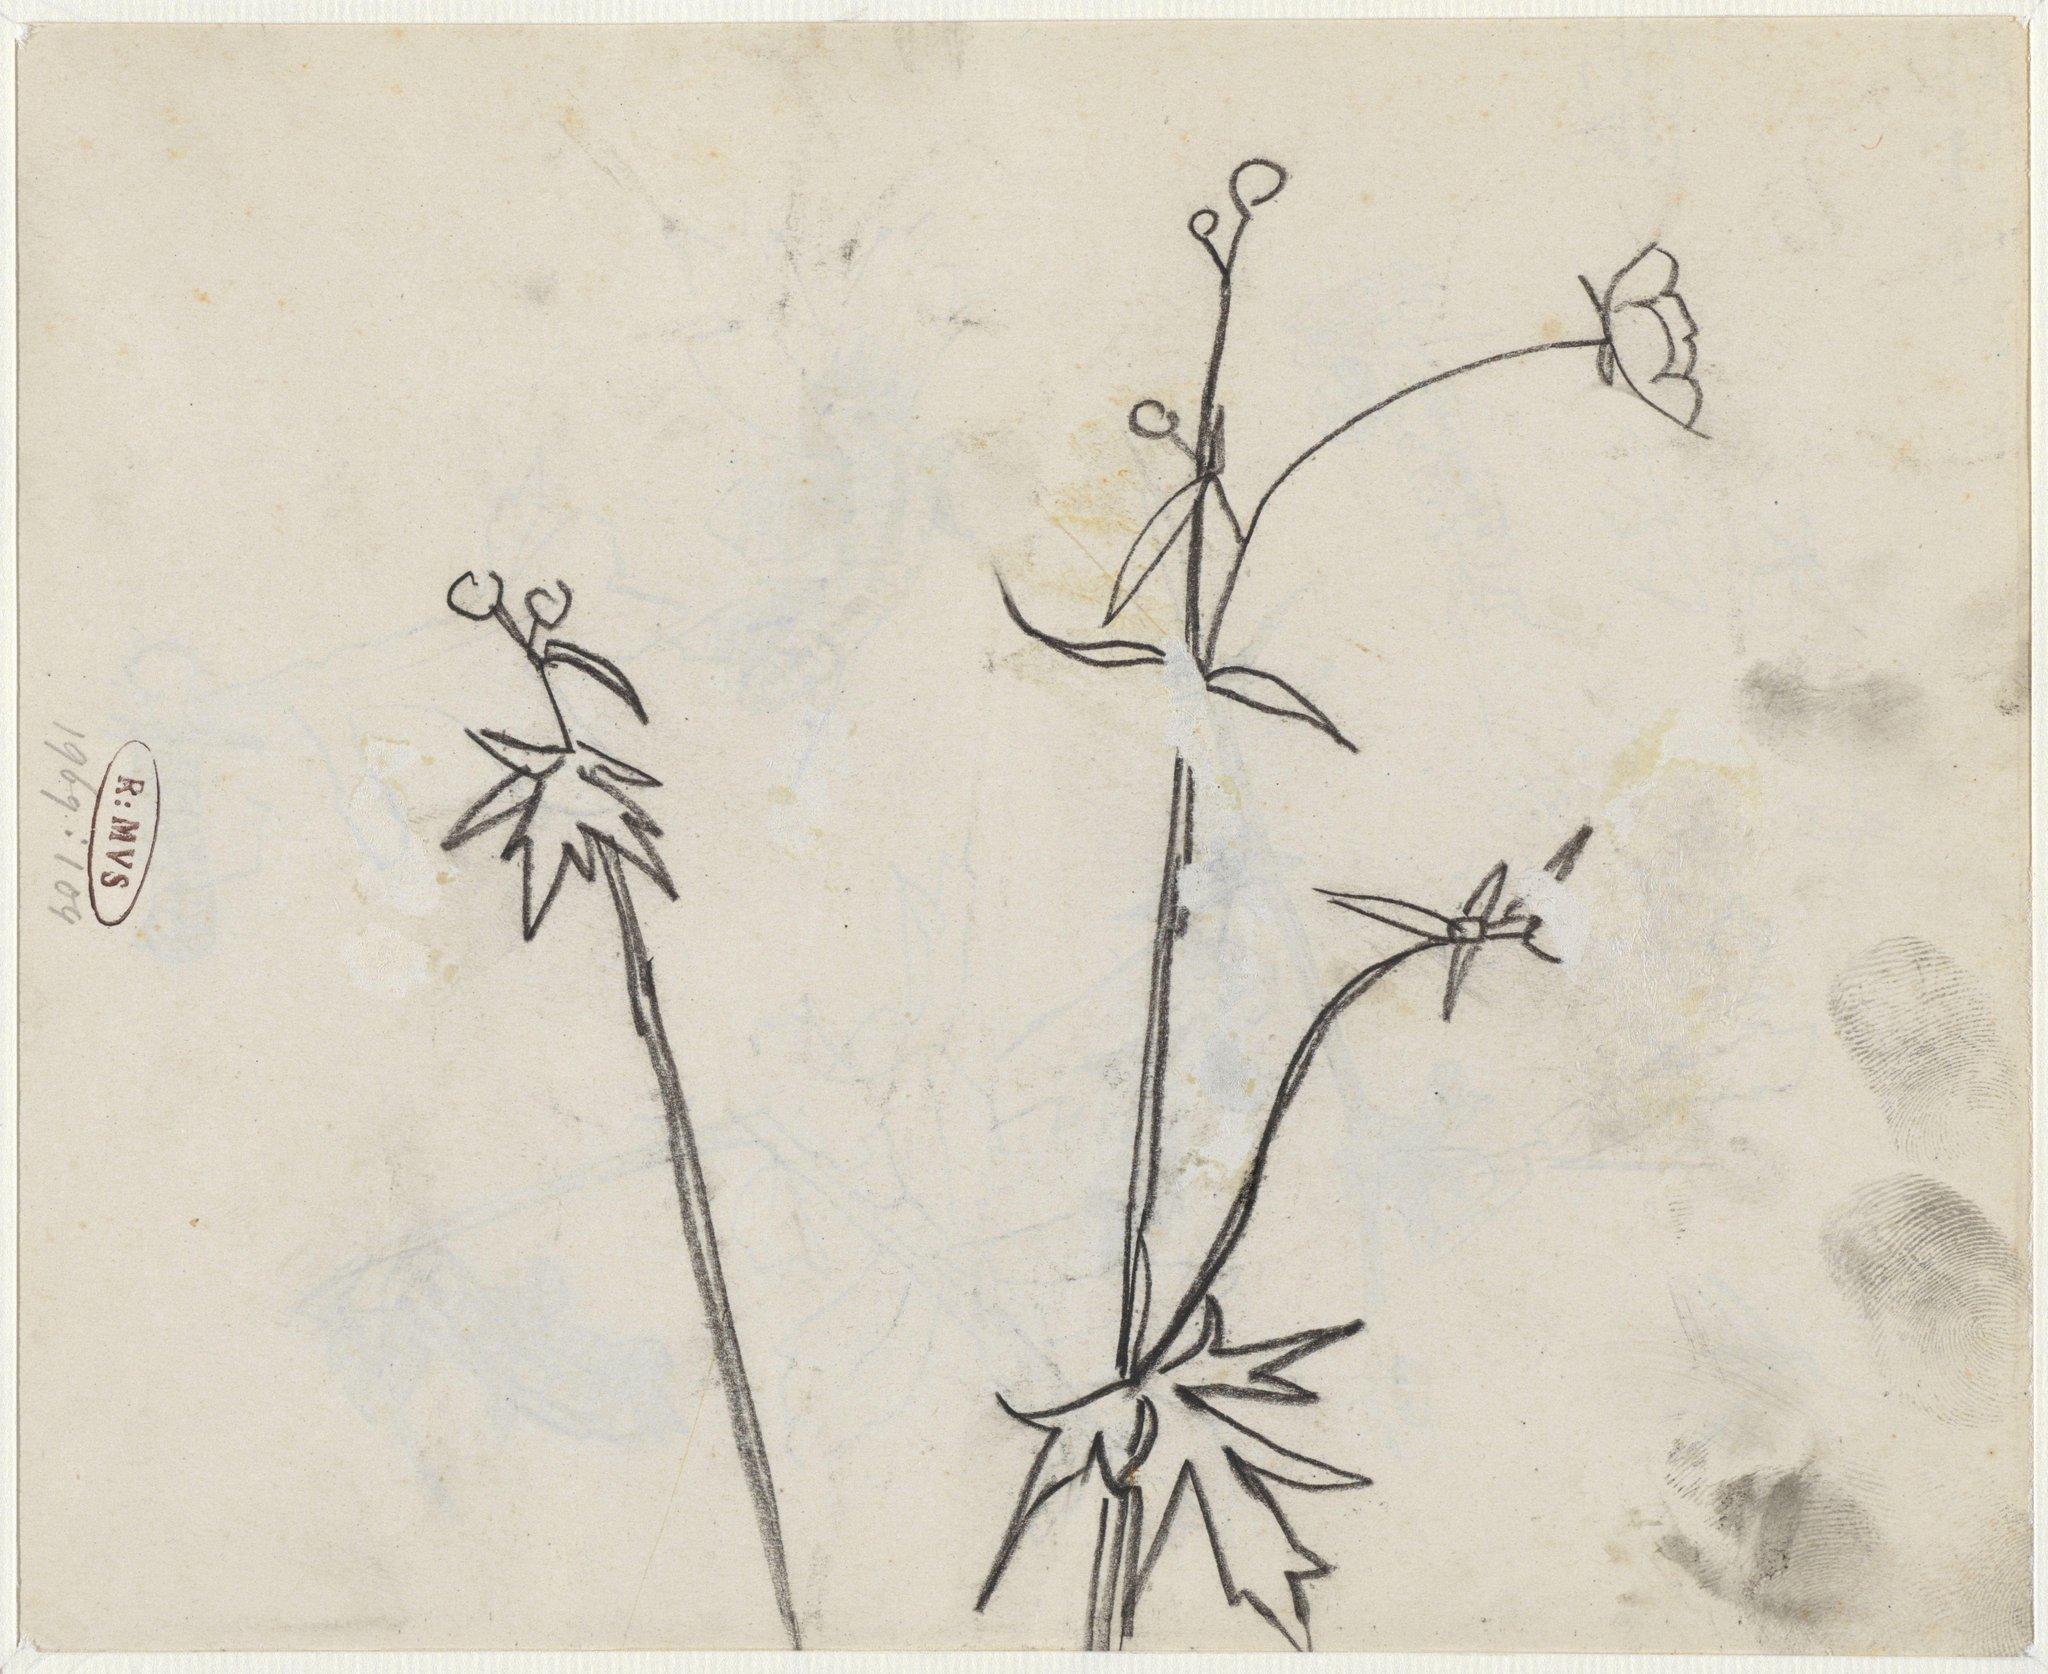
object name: drawing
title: Plantenstudie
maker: theo nieuwenhuis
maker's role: designer, draughtsman, print maker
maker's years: 1866-1951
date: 1876-1951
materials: chalk, paper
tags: flowers